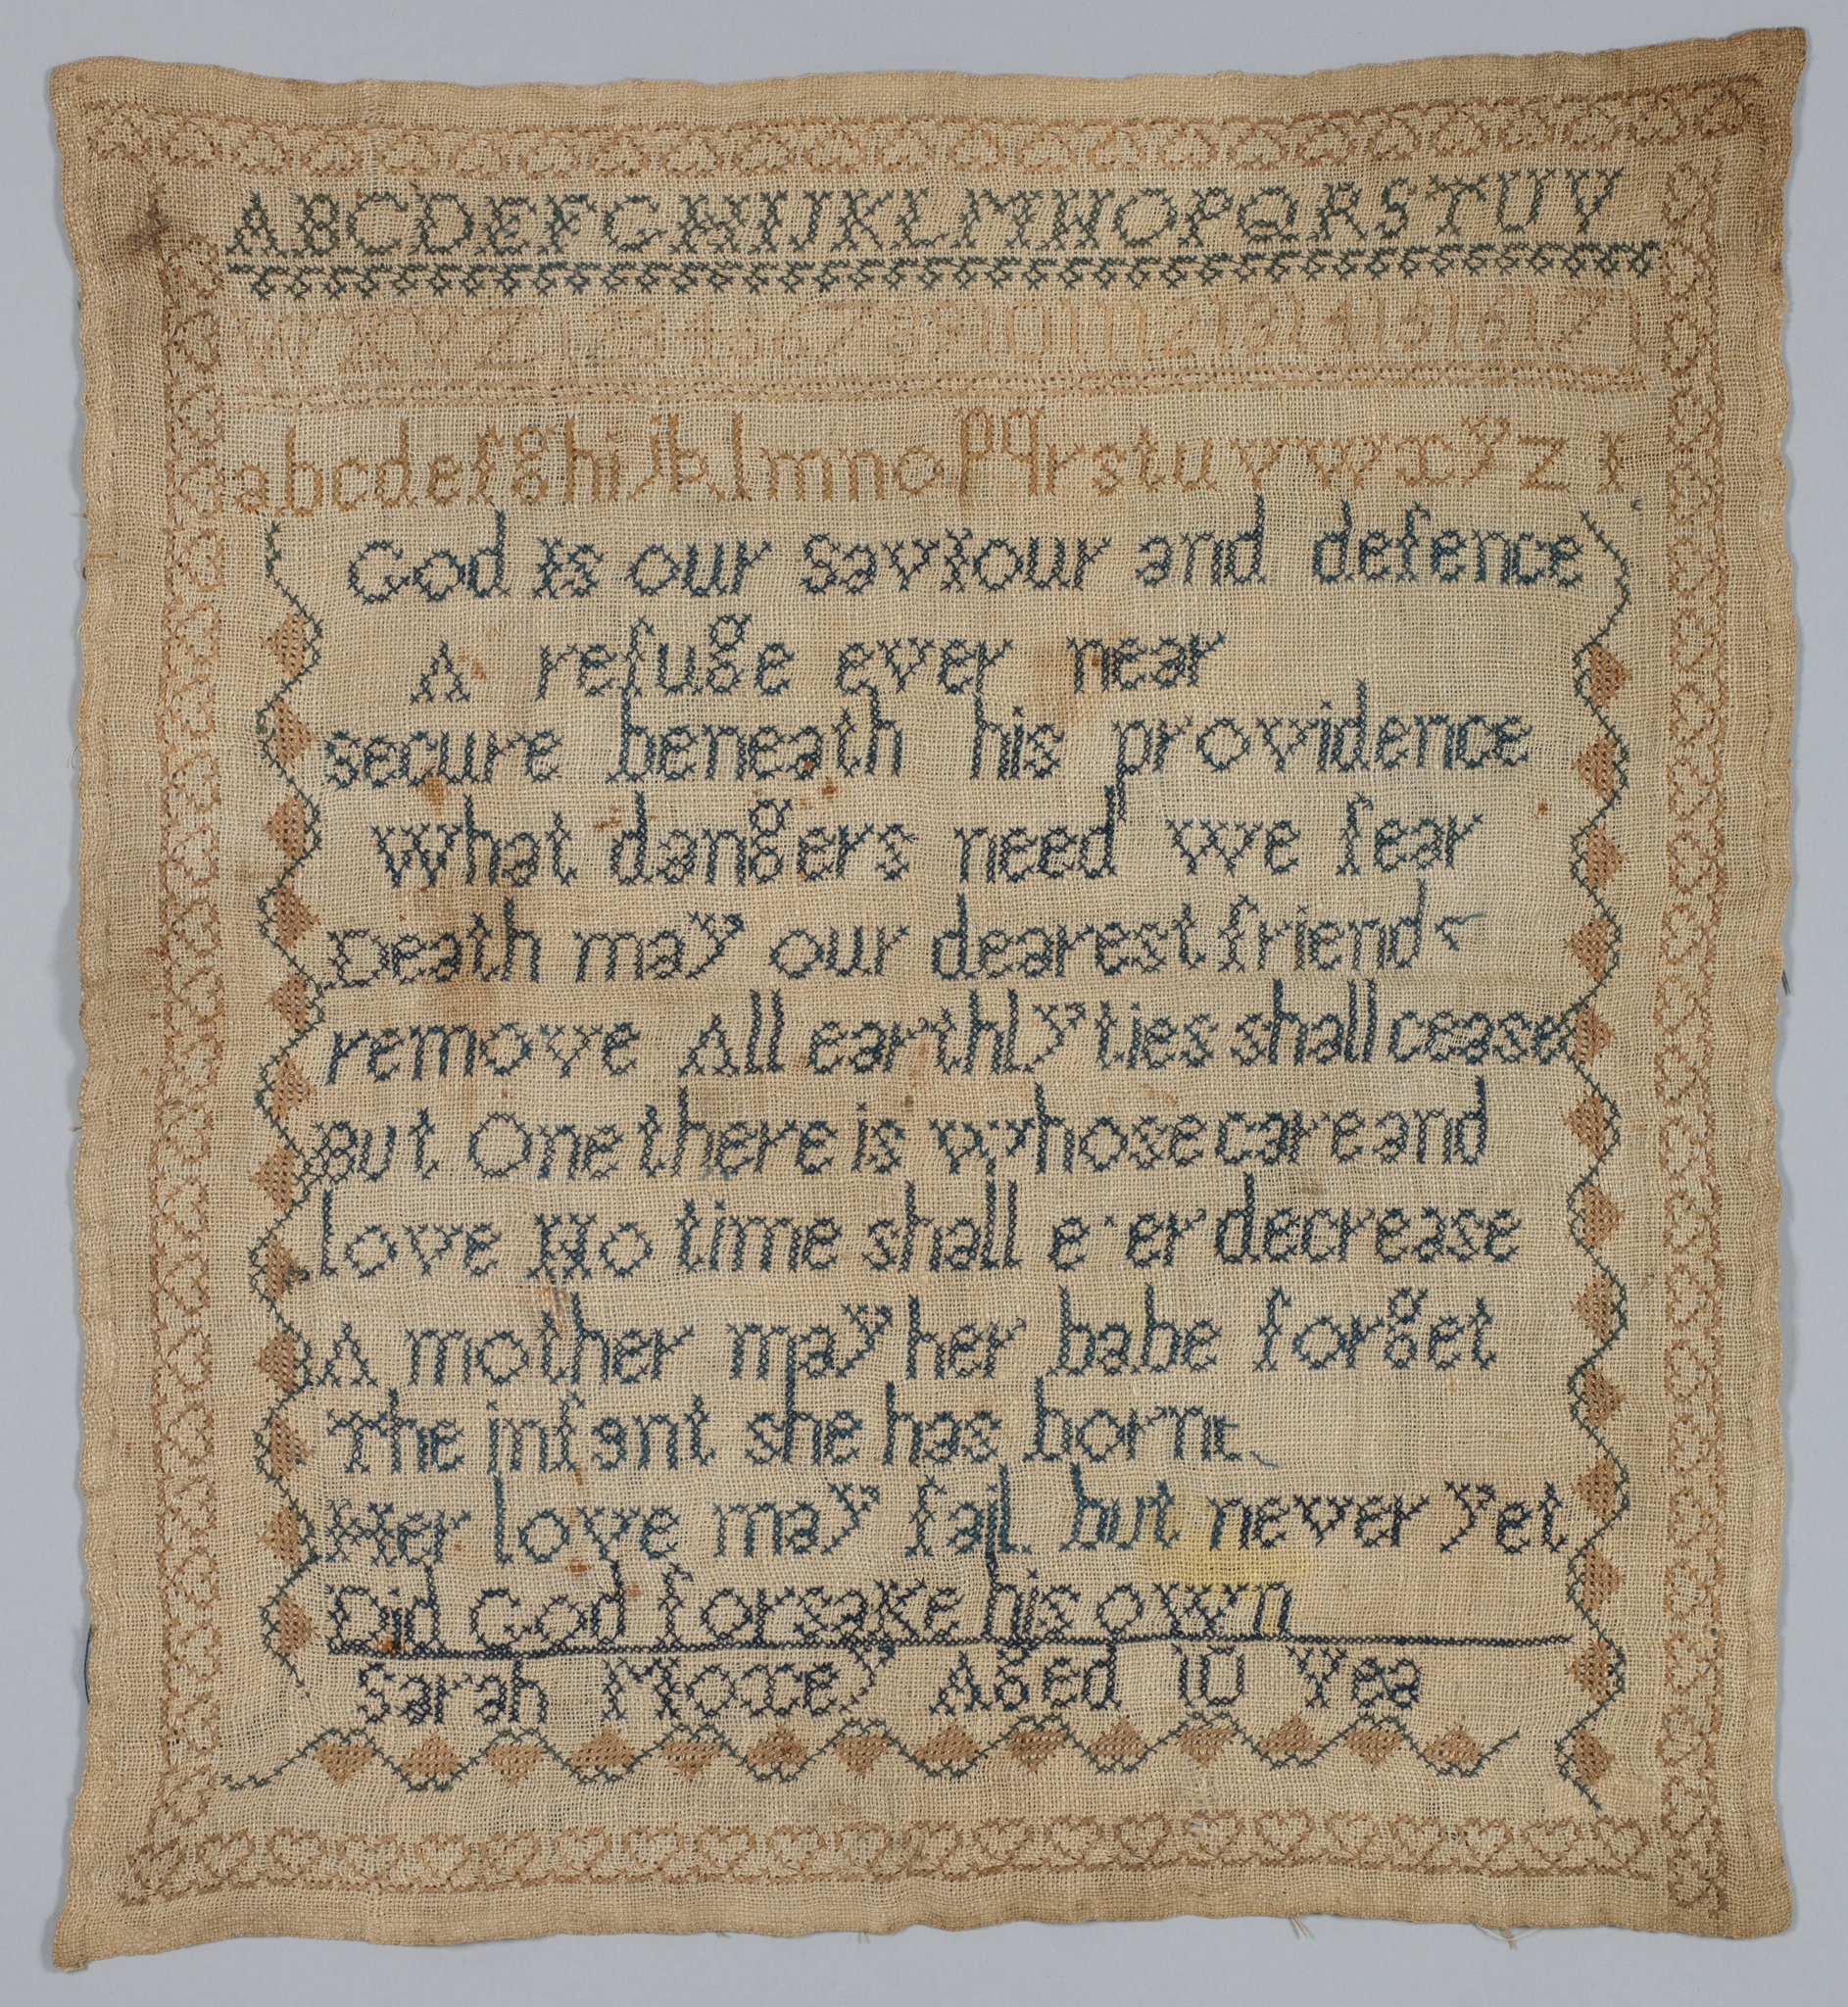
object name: sampler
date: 1834-1866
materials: canvas, linen